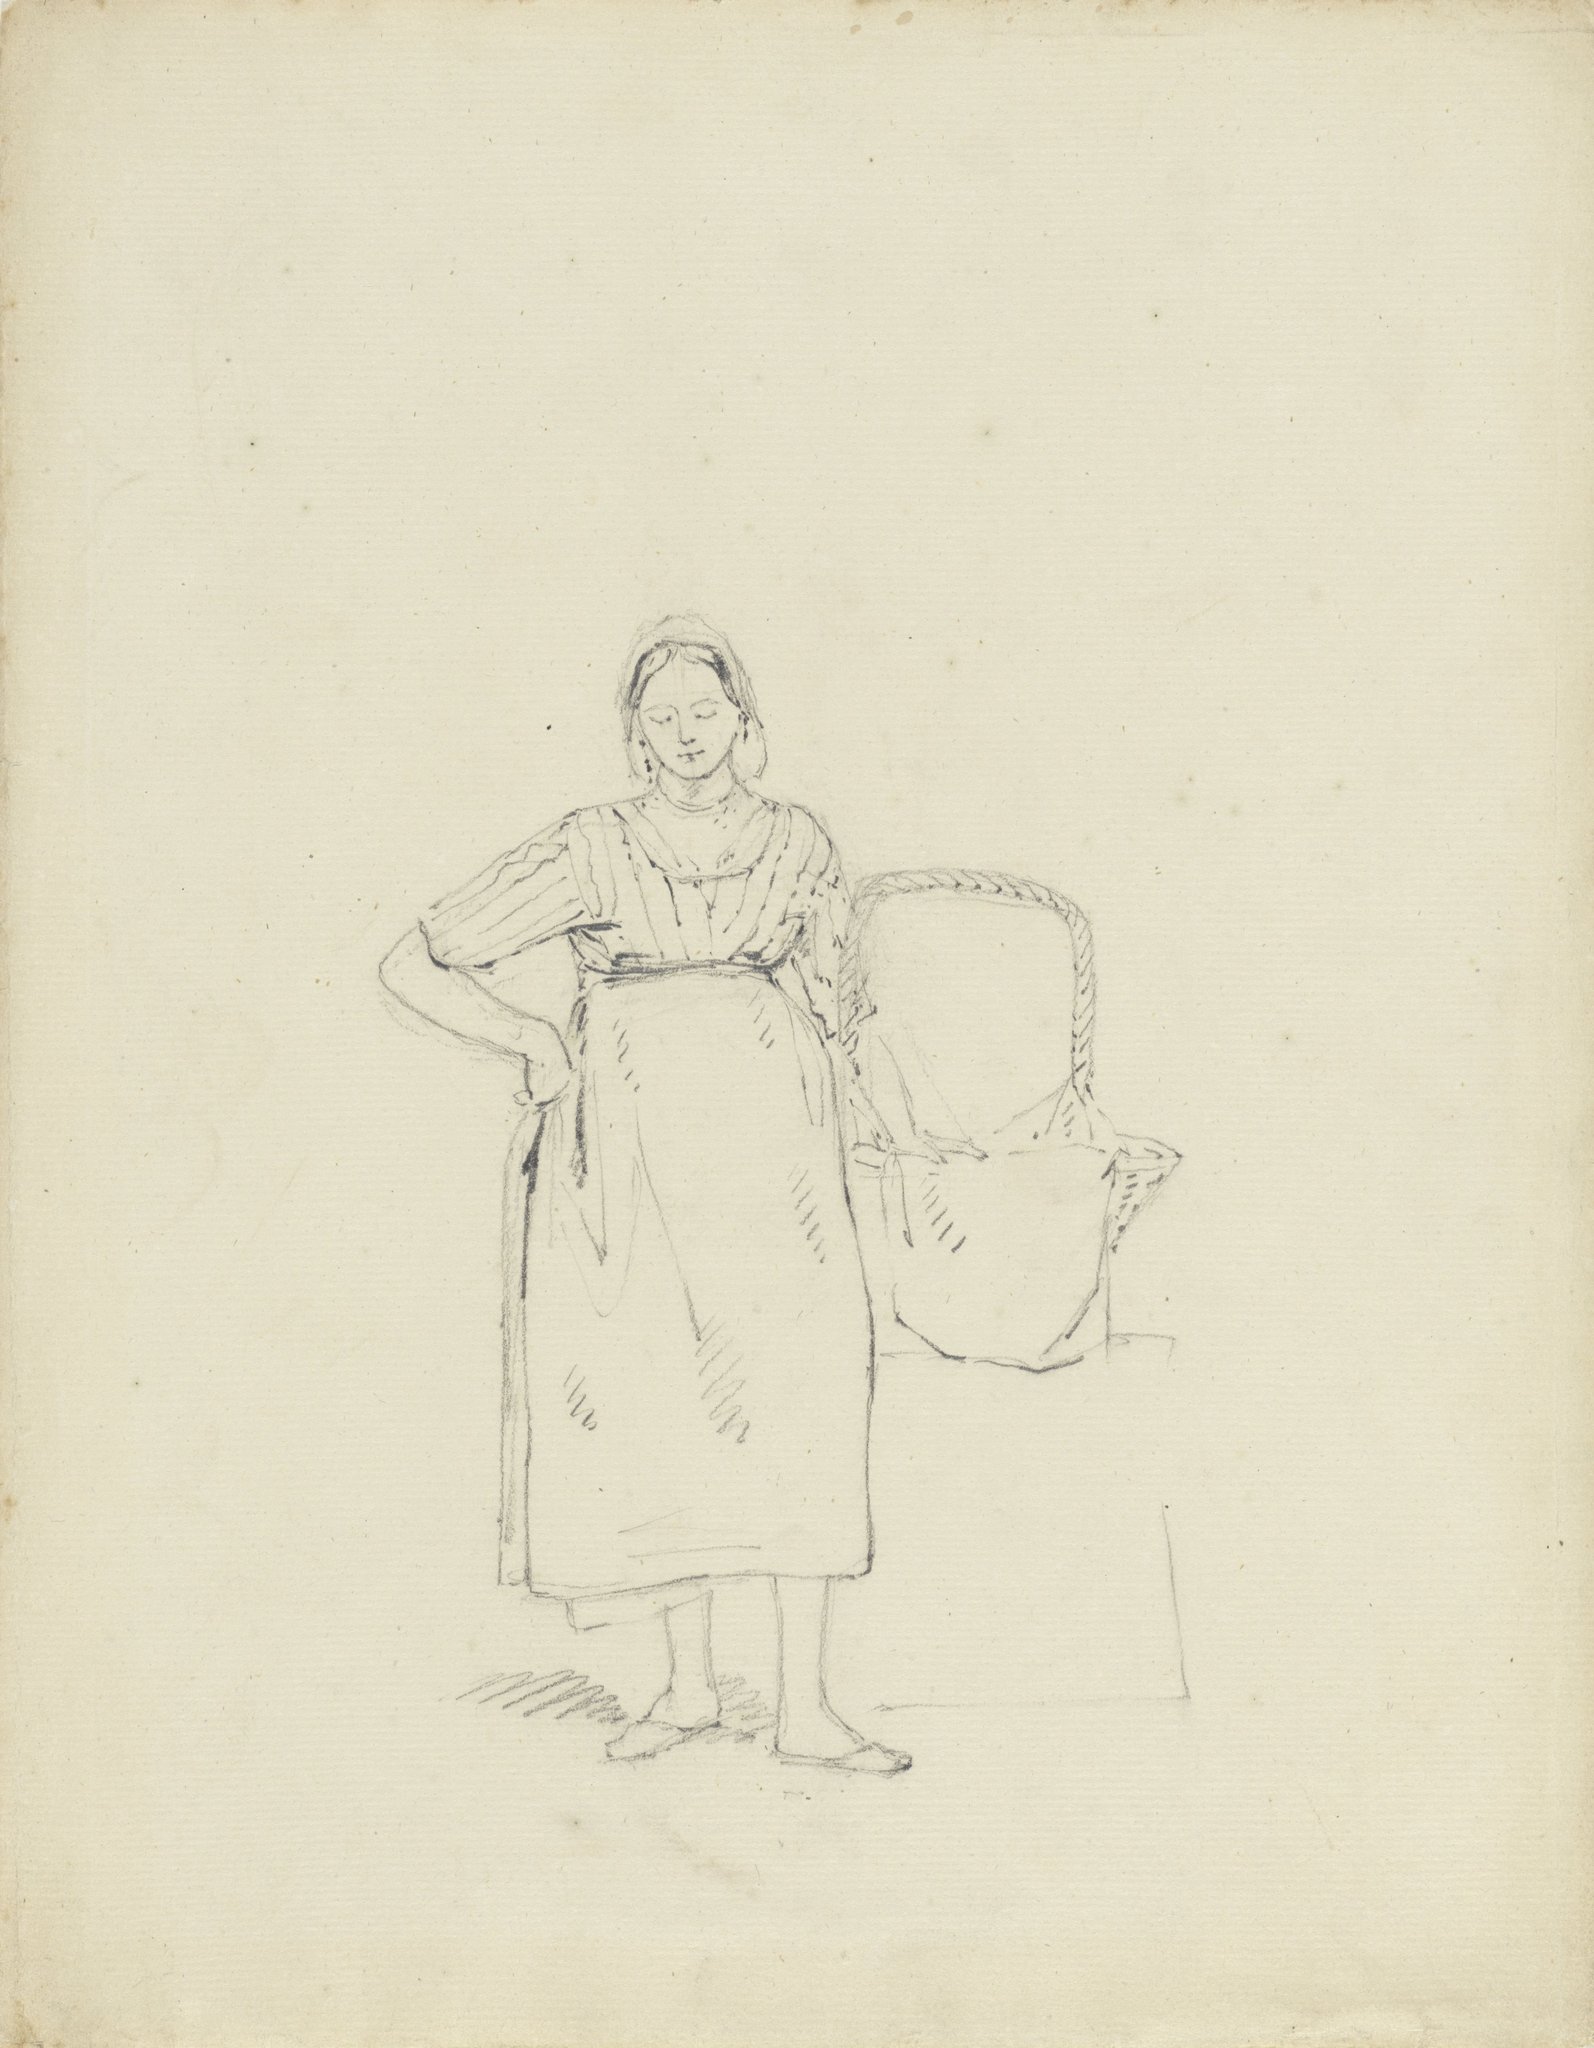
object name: drawing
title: Schets van een staande vrouw met een mand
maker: pieter van loon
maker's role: draughtsman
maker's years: 1801-1873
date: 1811-1873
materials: paper, pencil